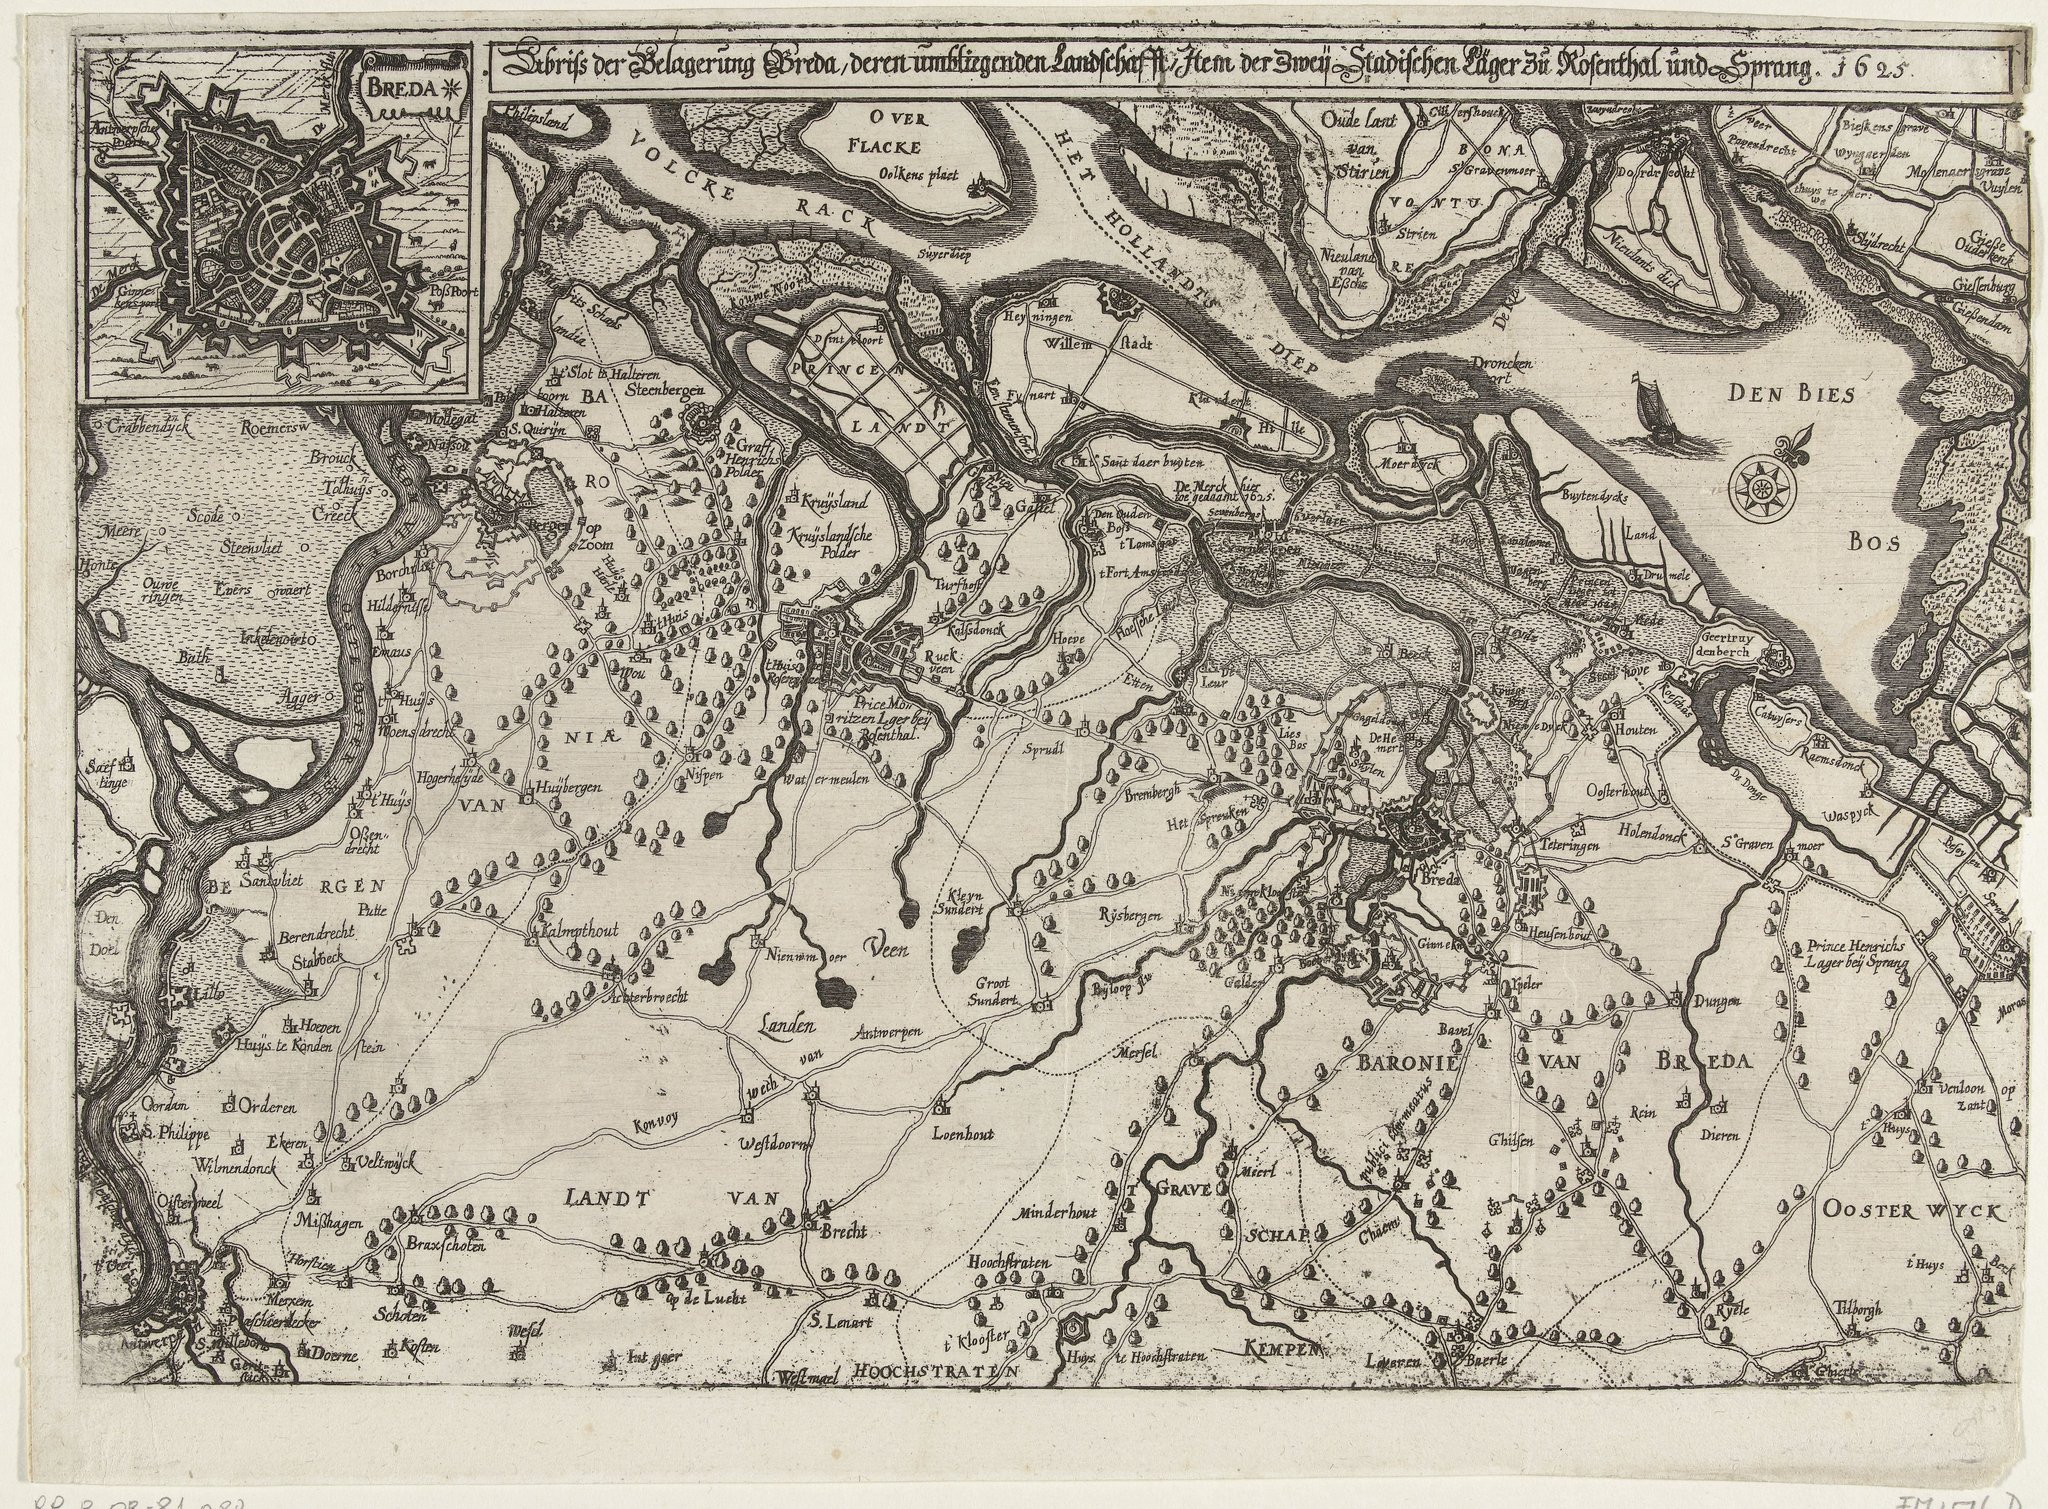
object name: print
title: Abriss der Belagerung Breda, deren umbliegenden Landschafft, Item der Zweij Stadischen Läger zu Rosenthal und Sprang. 1625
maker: Anonymous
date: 1625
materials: paper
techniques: etching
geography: germany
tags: delft, the hague, frederick henry (prince of orange), maurice (prince of orange), maps of separate countries or regions, siege, position war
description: Kaart van het beleg van Breda door het Spaanse leger onder Spinola, 27 augustus 1624 tot 5 juni 1625. Breda met een groot deel van het omliggende land en de legerplaatsen van de belegerende troepen bij Ginneken en van de Staatse legers onder Maurits bij Roosendaal en onder Frederik Hendrik bij Sprang. Aan de linkerzijde de Schelde en Antwerpen, bovenaan het Hollands Diep en de Biesbos. Linksboven een inzet met een plattegrond van Breda.